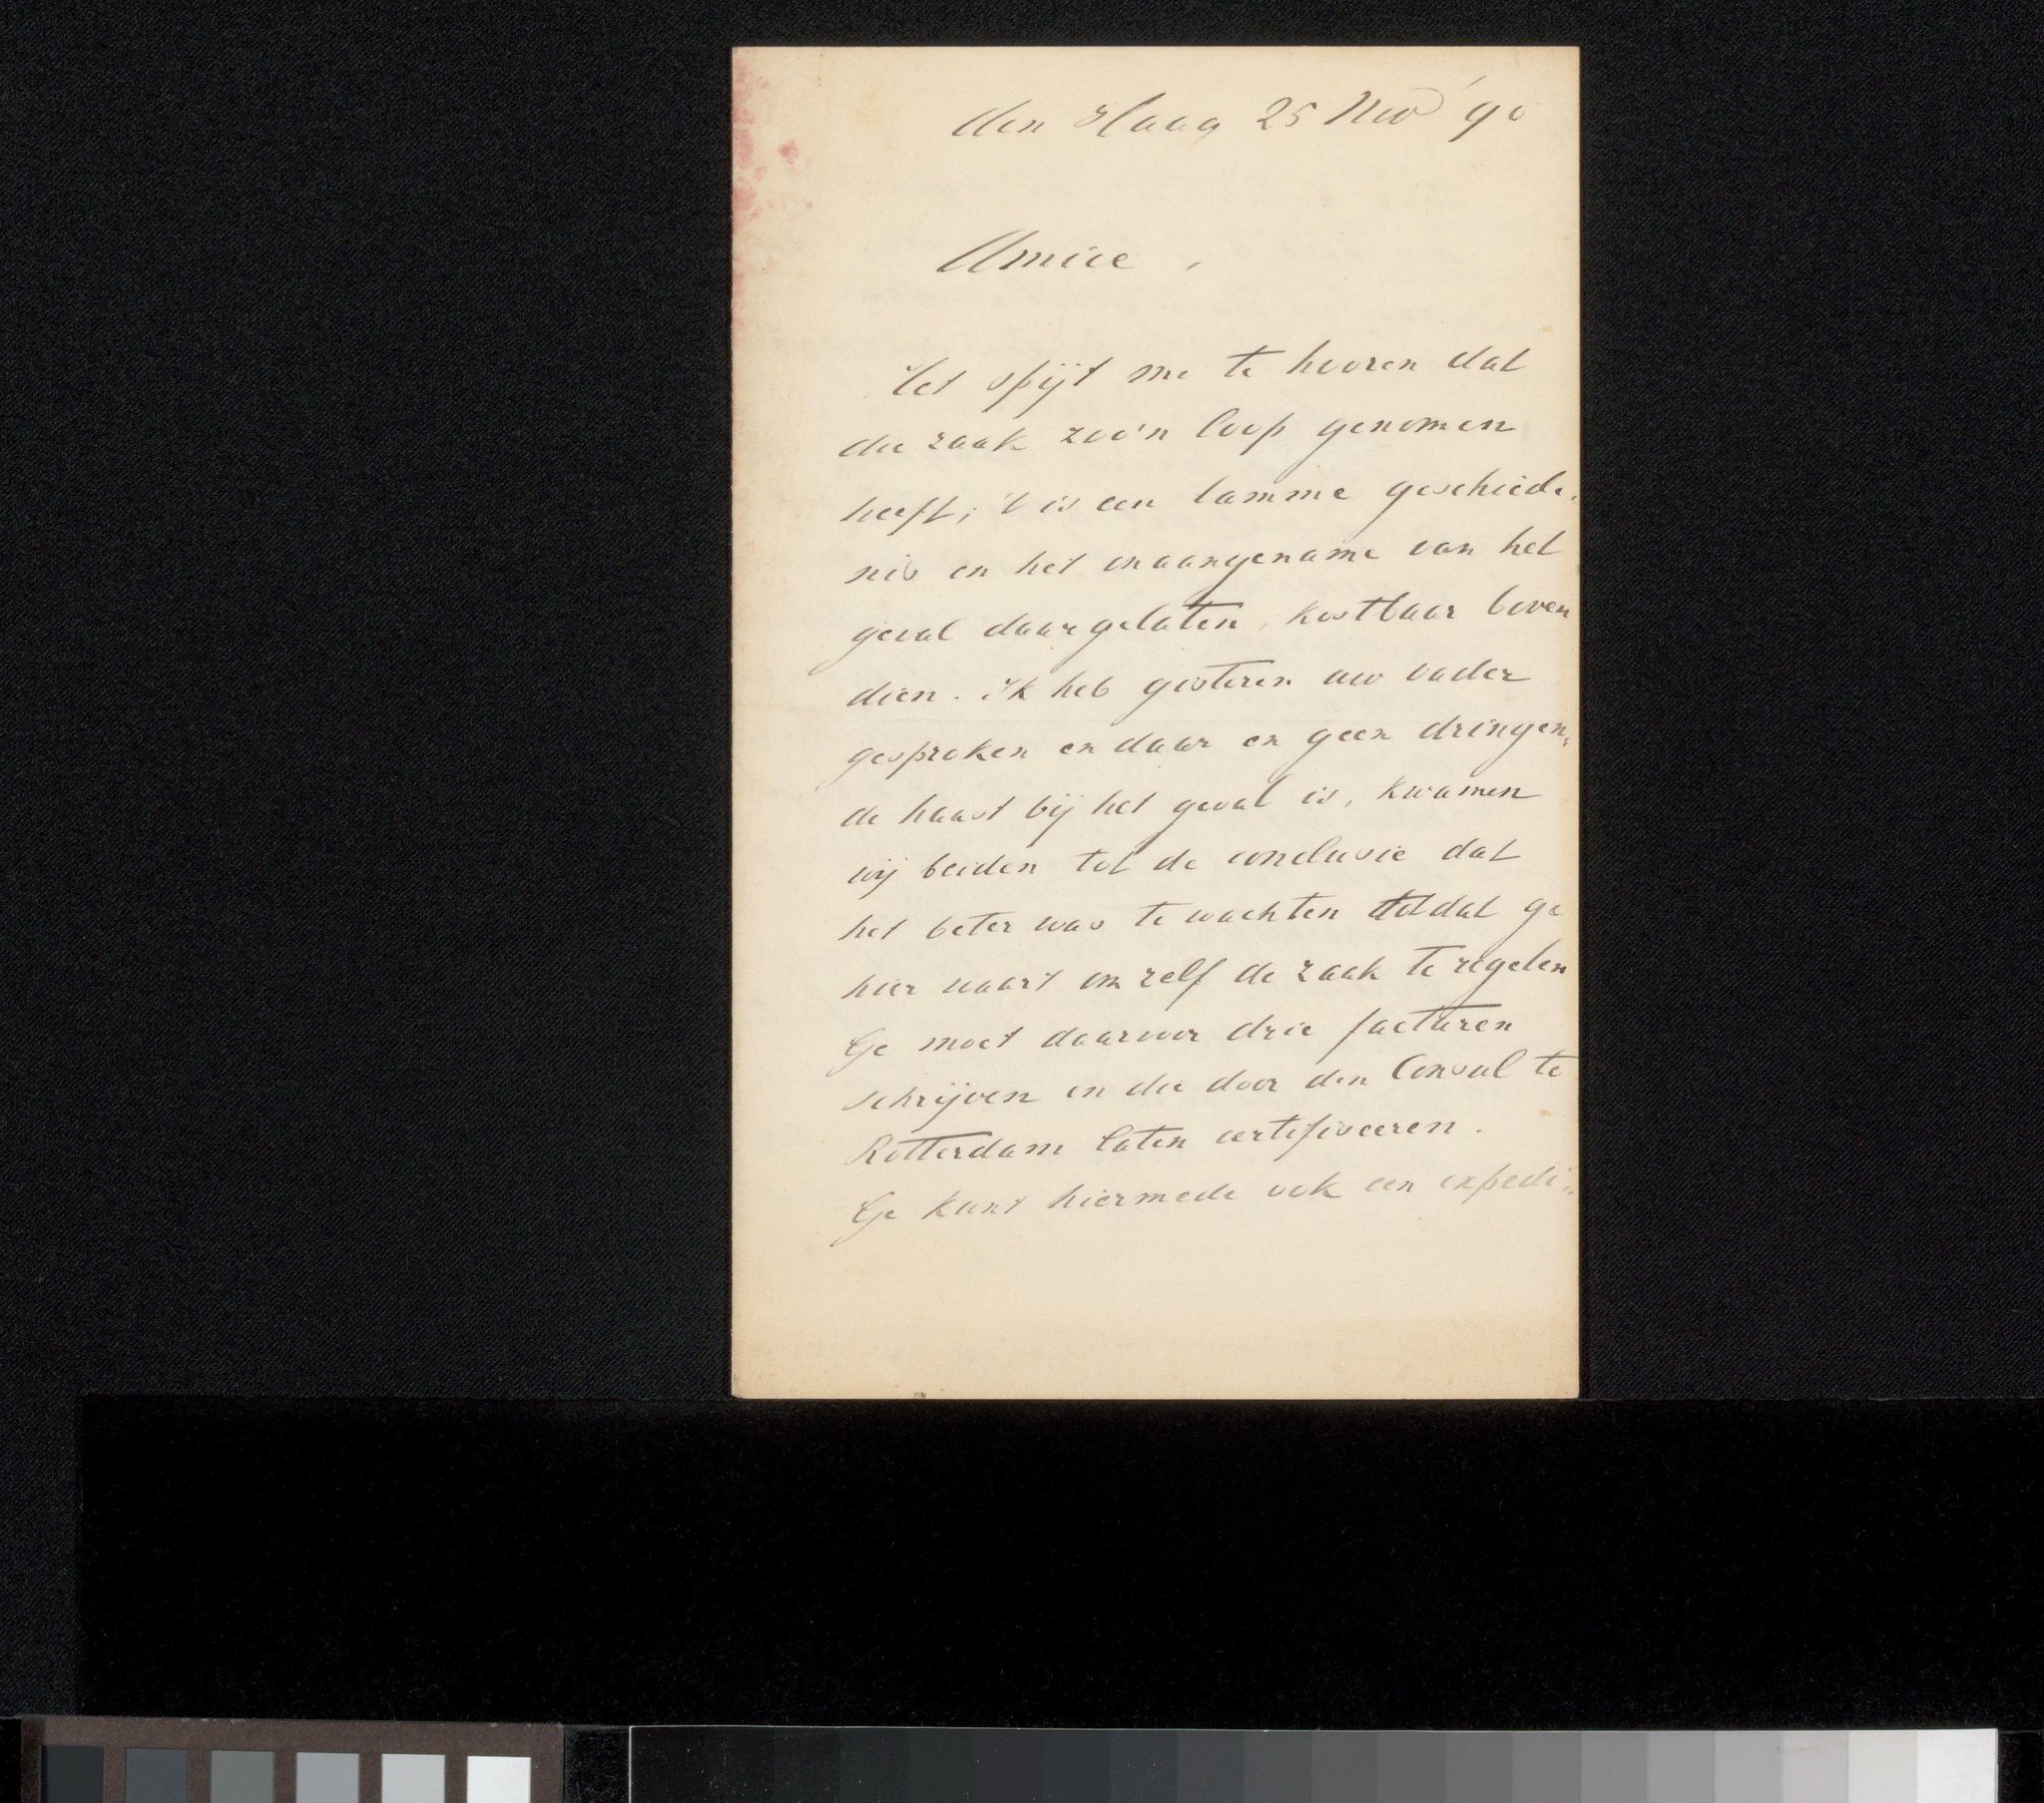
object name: letter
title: Brief aan Philip Zilcken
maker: elbert jan van wisselingh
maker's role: kunsthandelaar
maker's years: 1848-1912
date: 1890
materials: ink, paper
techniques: pen, writing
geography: the hague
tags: painter, draughtsman, philip zilcken, exhibition ~ art, money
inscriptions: watermark, collector's mark: ‘RPK’